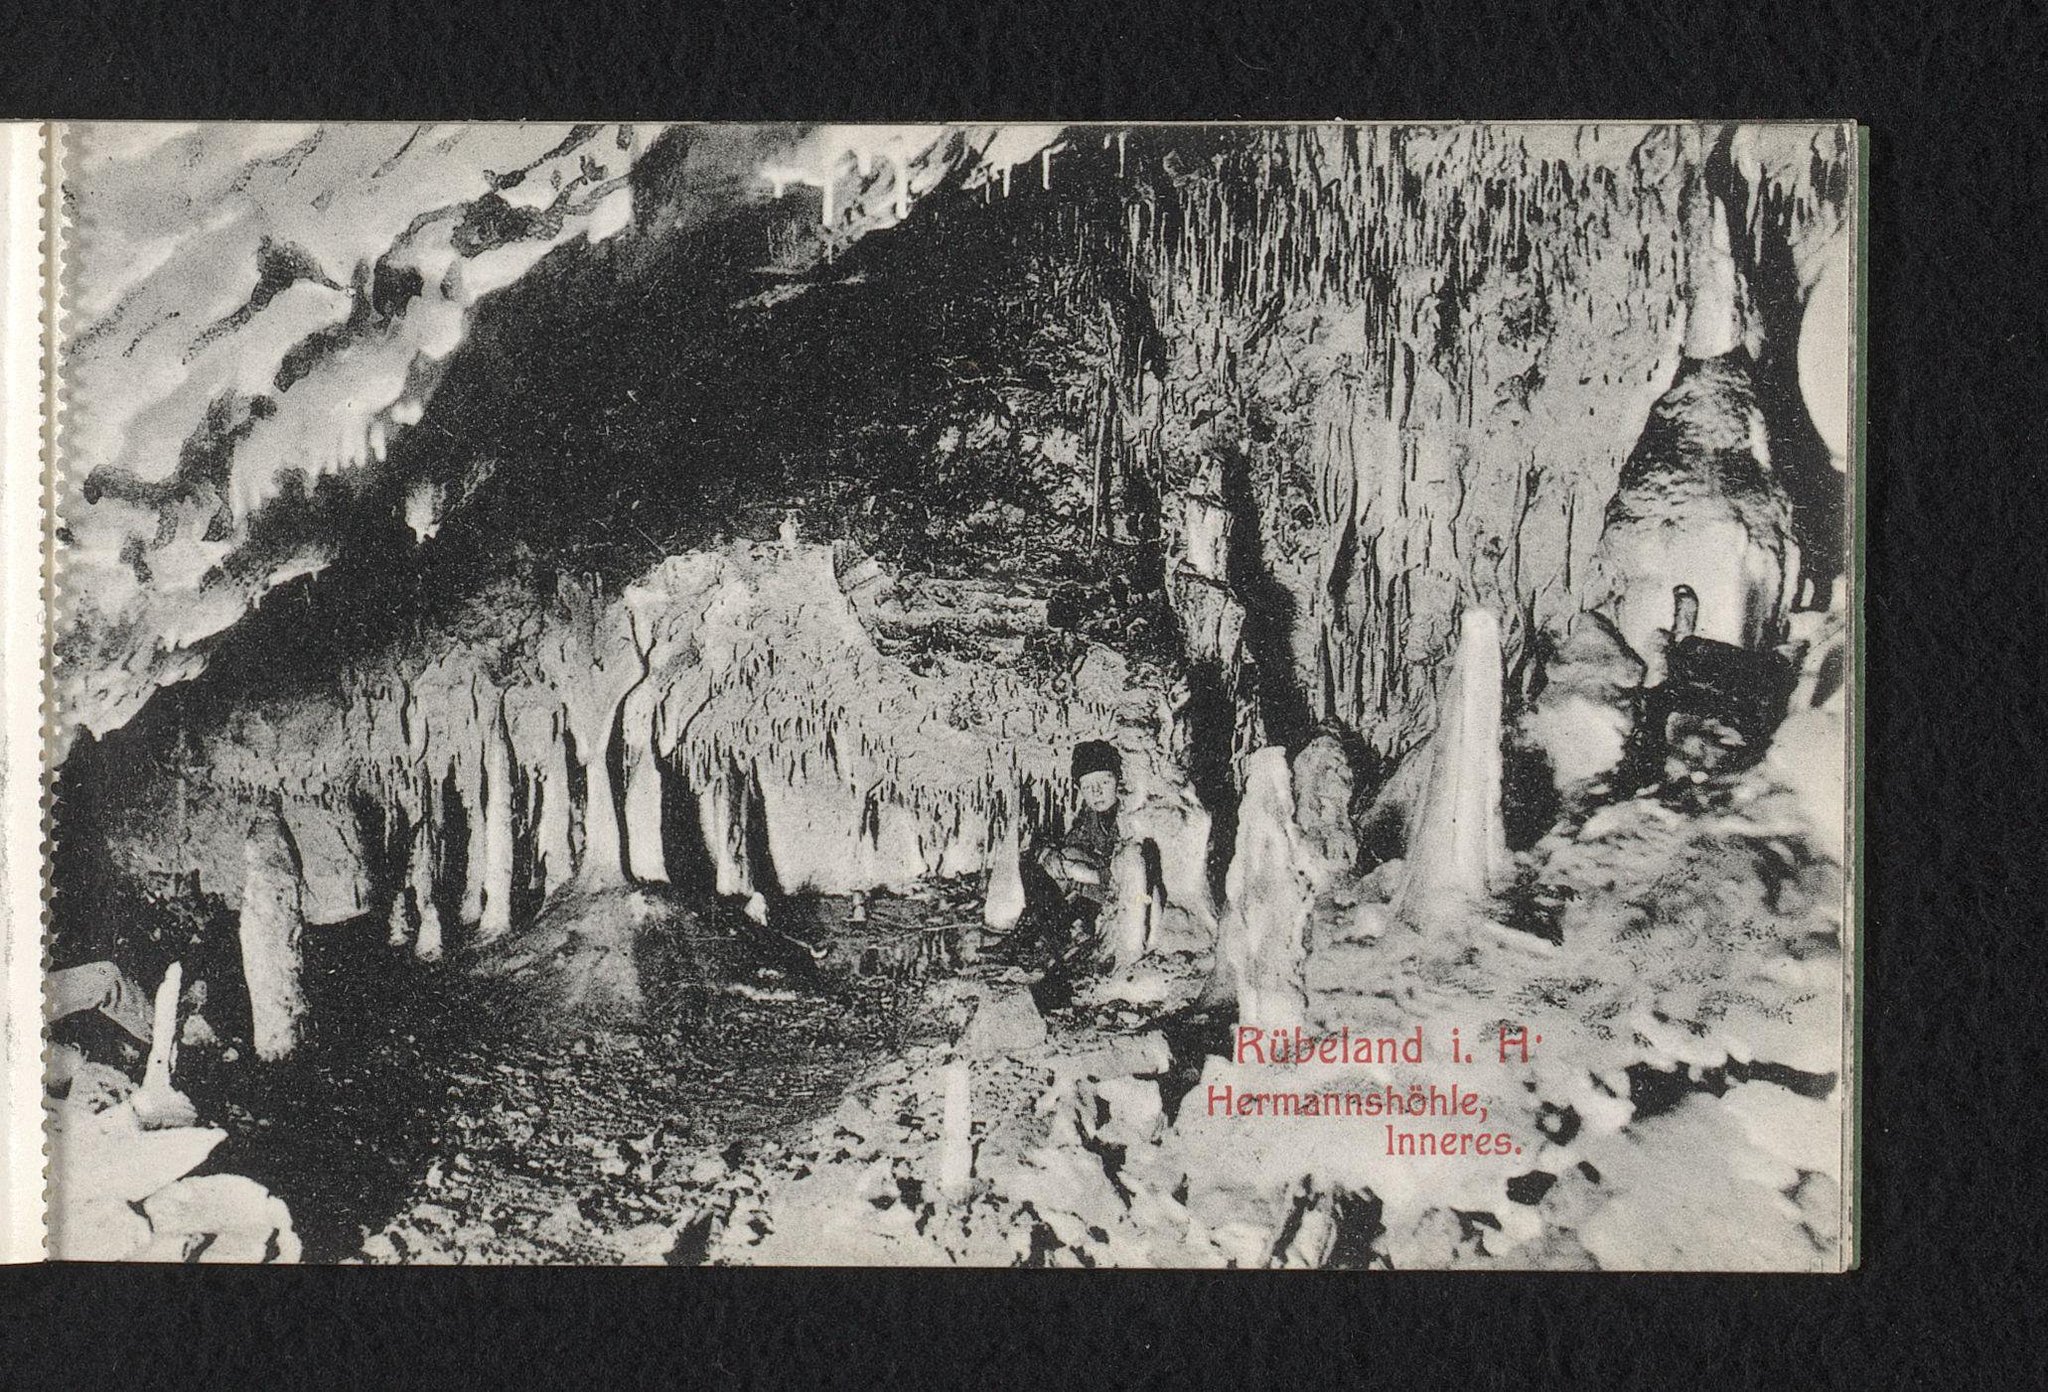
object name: photomechanical print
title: Rübeland i. H. Hermannshöhle, Inneres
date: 1907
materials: cardboard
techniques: photograph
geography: halberstadt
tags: stalactitic cave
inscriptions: date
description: Prentbriefkaart maakt deel uit van een album.